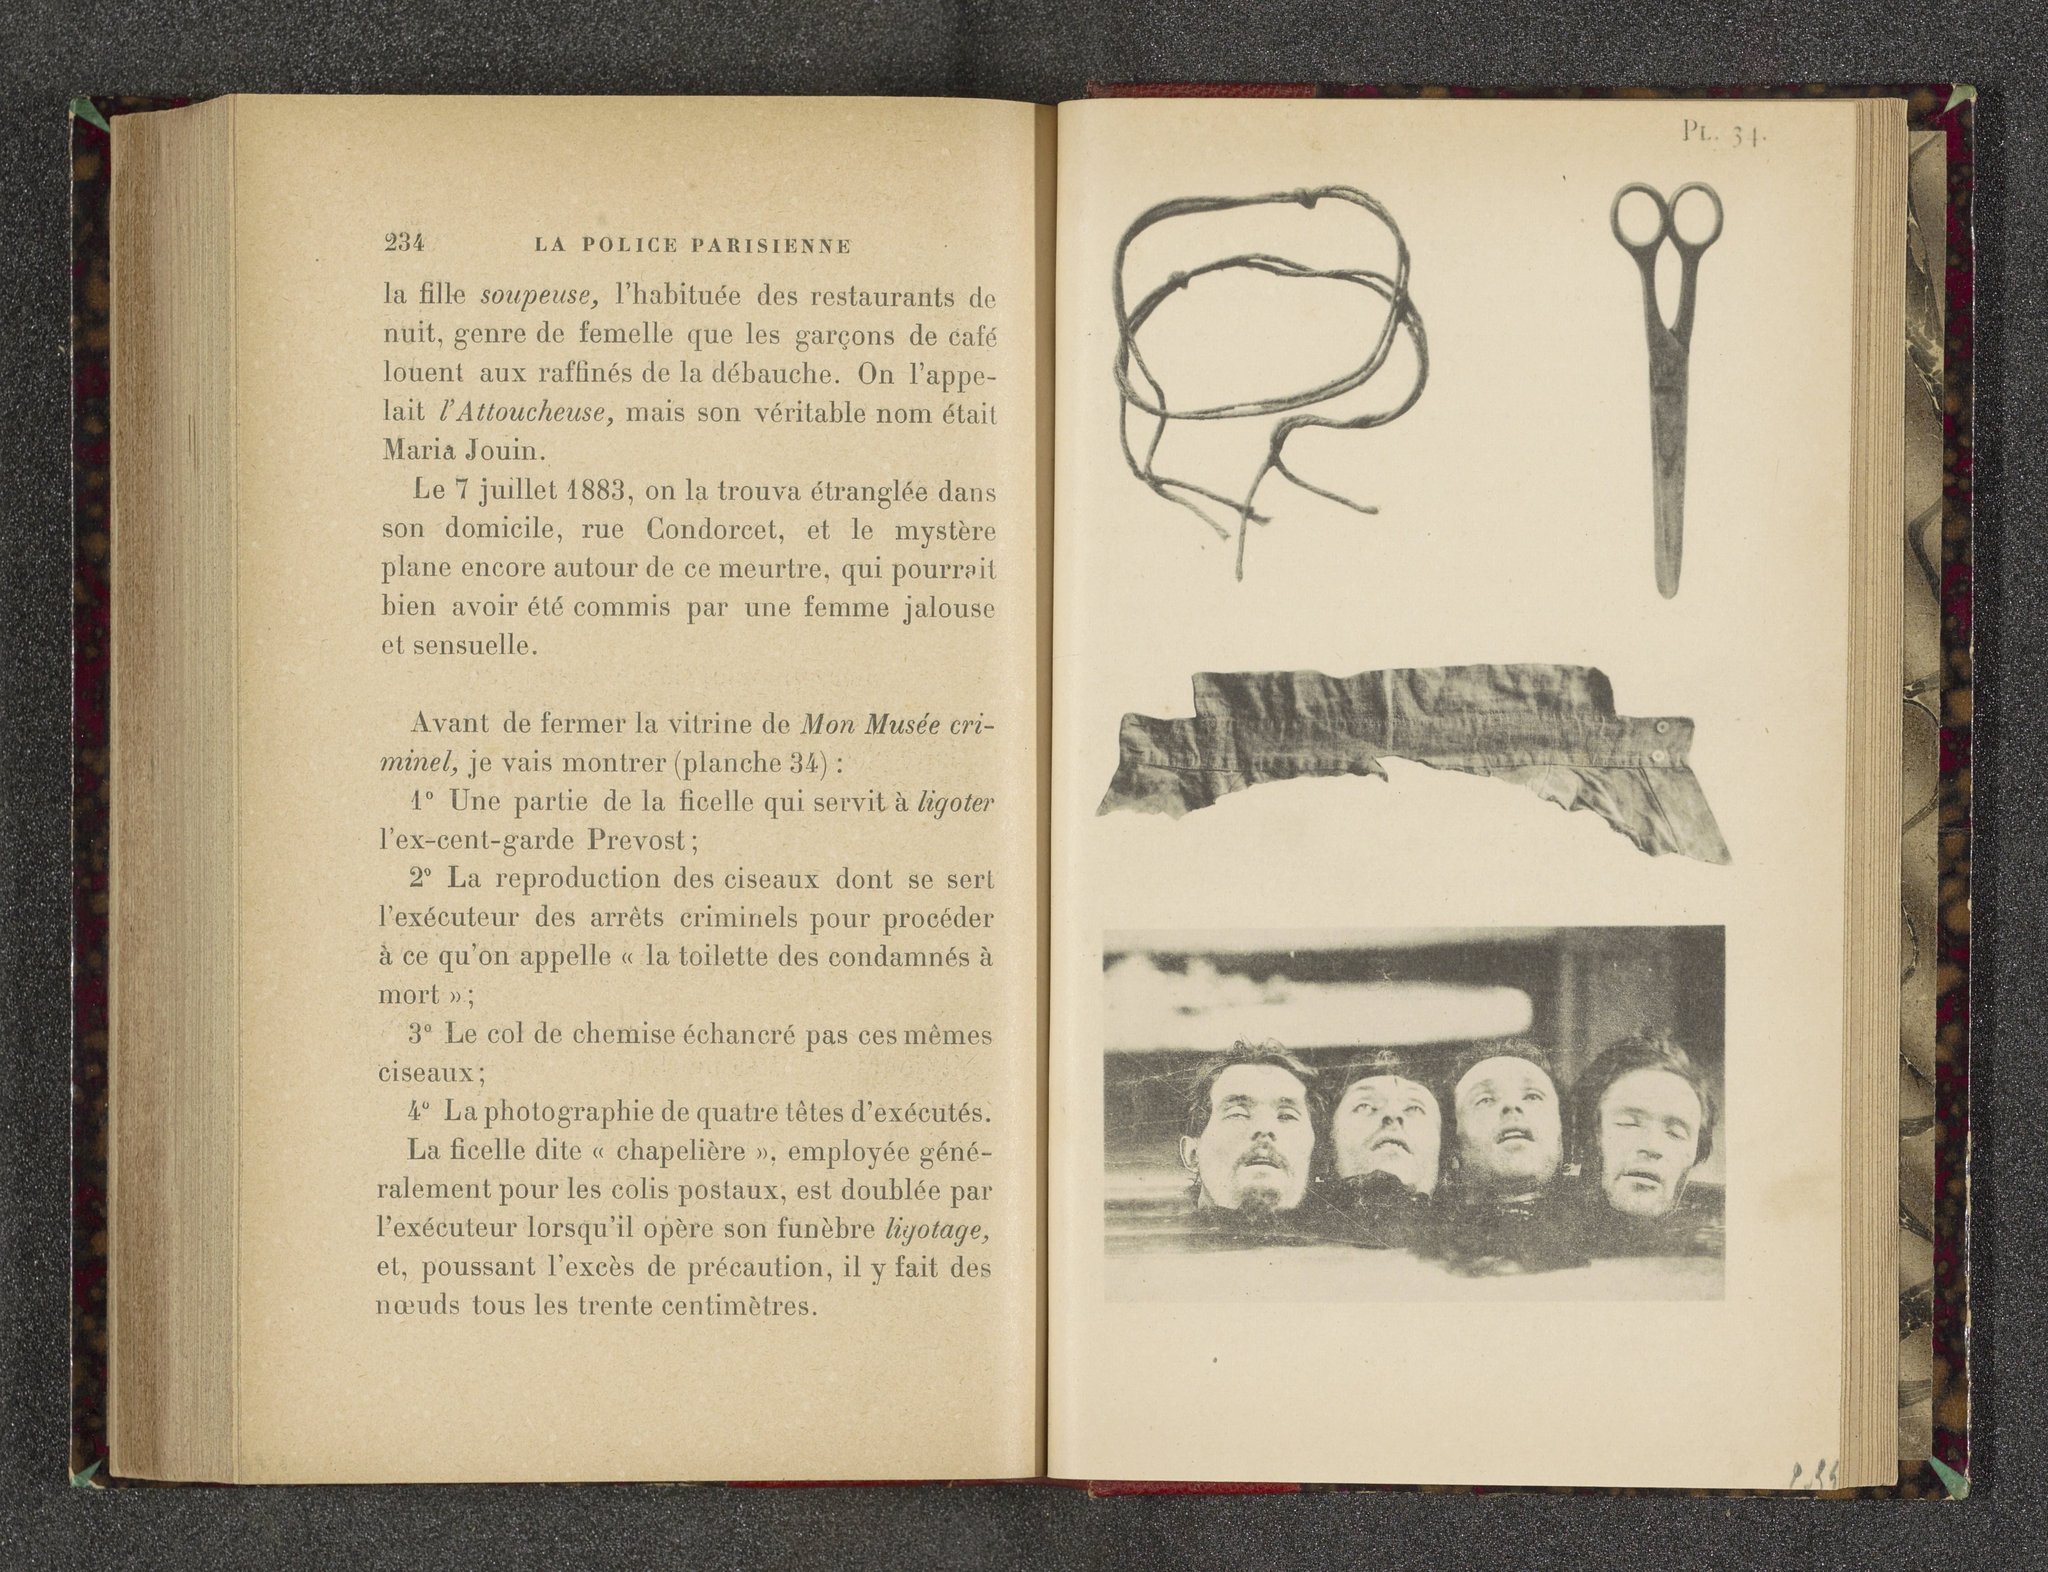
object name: photomechanical print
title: Attributen en taferelen van de politie in Parijs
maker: Anonymous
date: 1880-1890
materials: paper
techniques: photograph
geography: paris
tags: head of a beheaded person, criminals, police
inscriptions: number: ‘Pl. 34.’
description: Boven: touw en een schaar om straffen mee uit te voeren, midden: een boord van een overhemd, onder: vier hoofden na onthoofding.